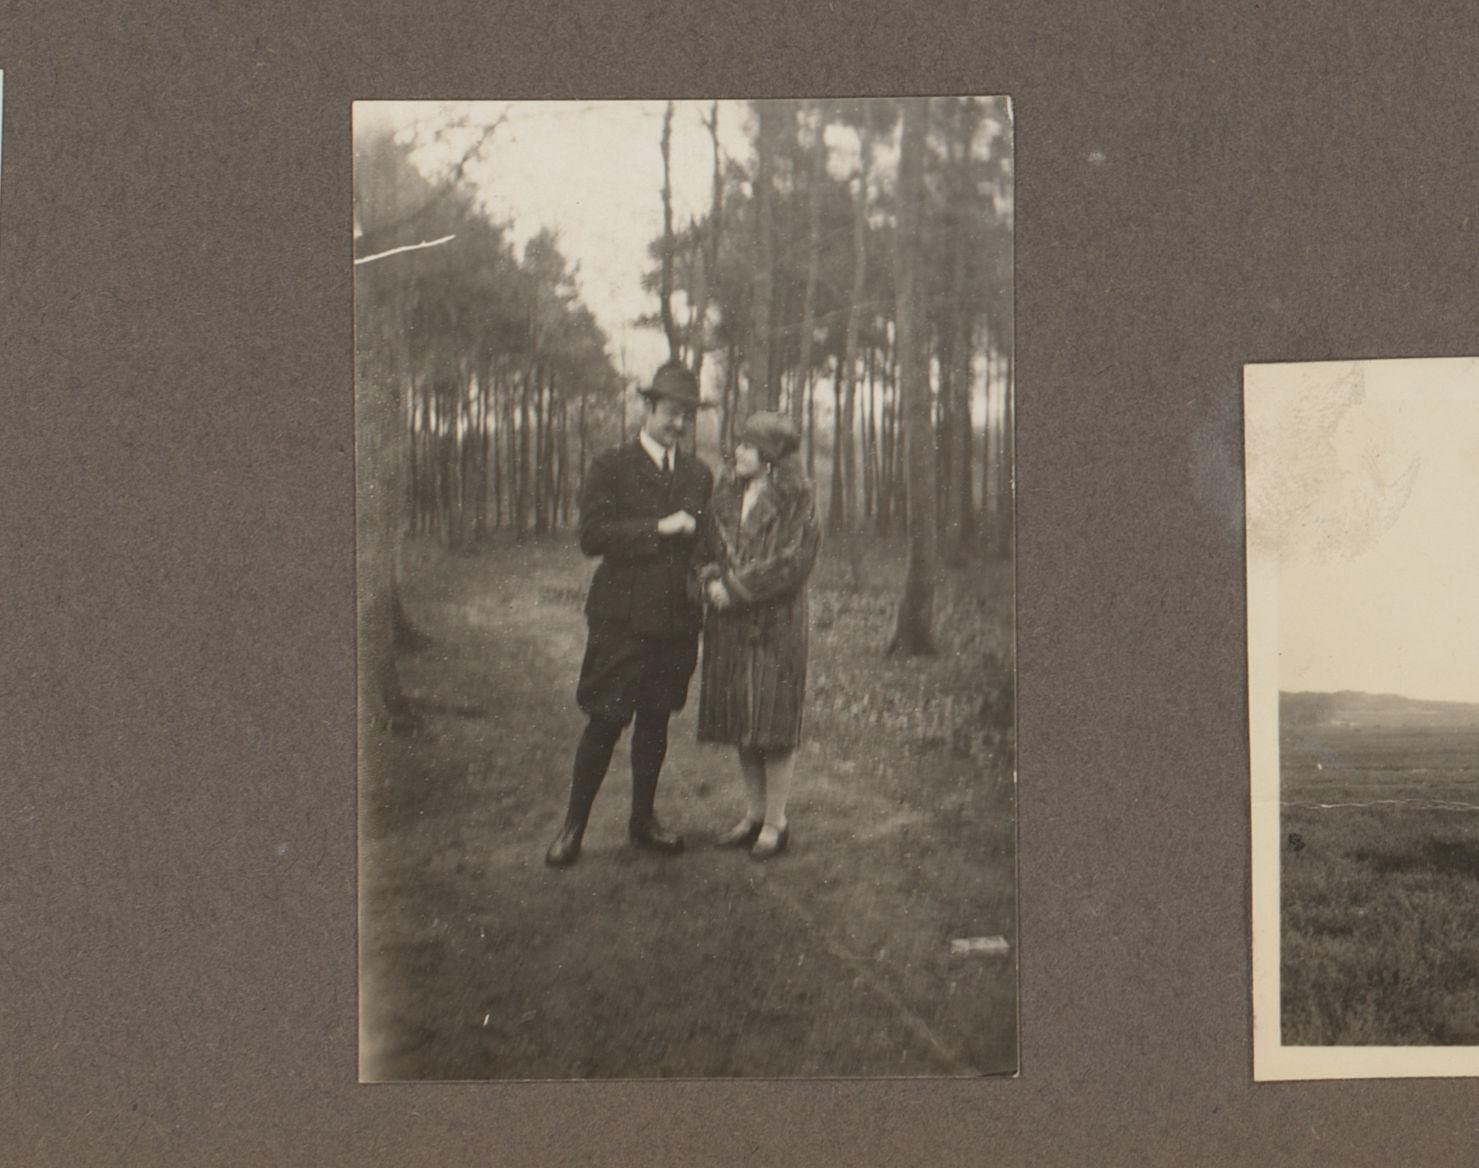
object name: photograph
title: Johannes van Zijll de Jong en Henriëtte Wassink op bosweg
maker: Anonymous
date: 1930-1935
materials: paper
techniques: gelatin silver print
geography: netherlands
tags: henriëtte wassink, mother and son(s) (family group), forest path or lane, netherlands